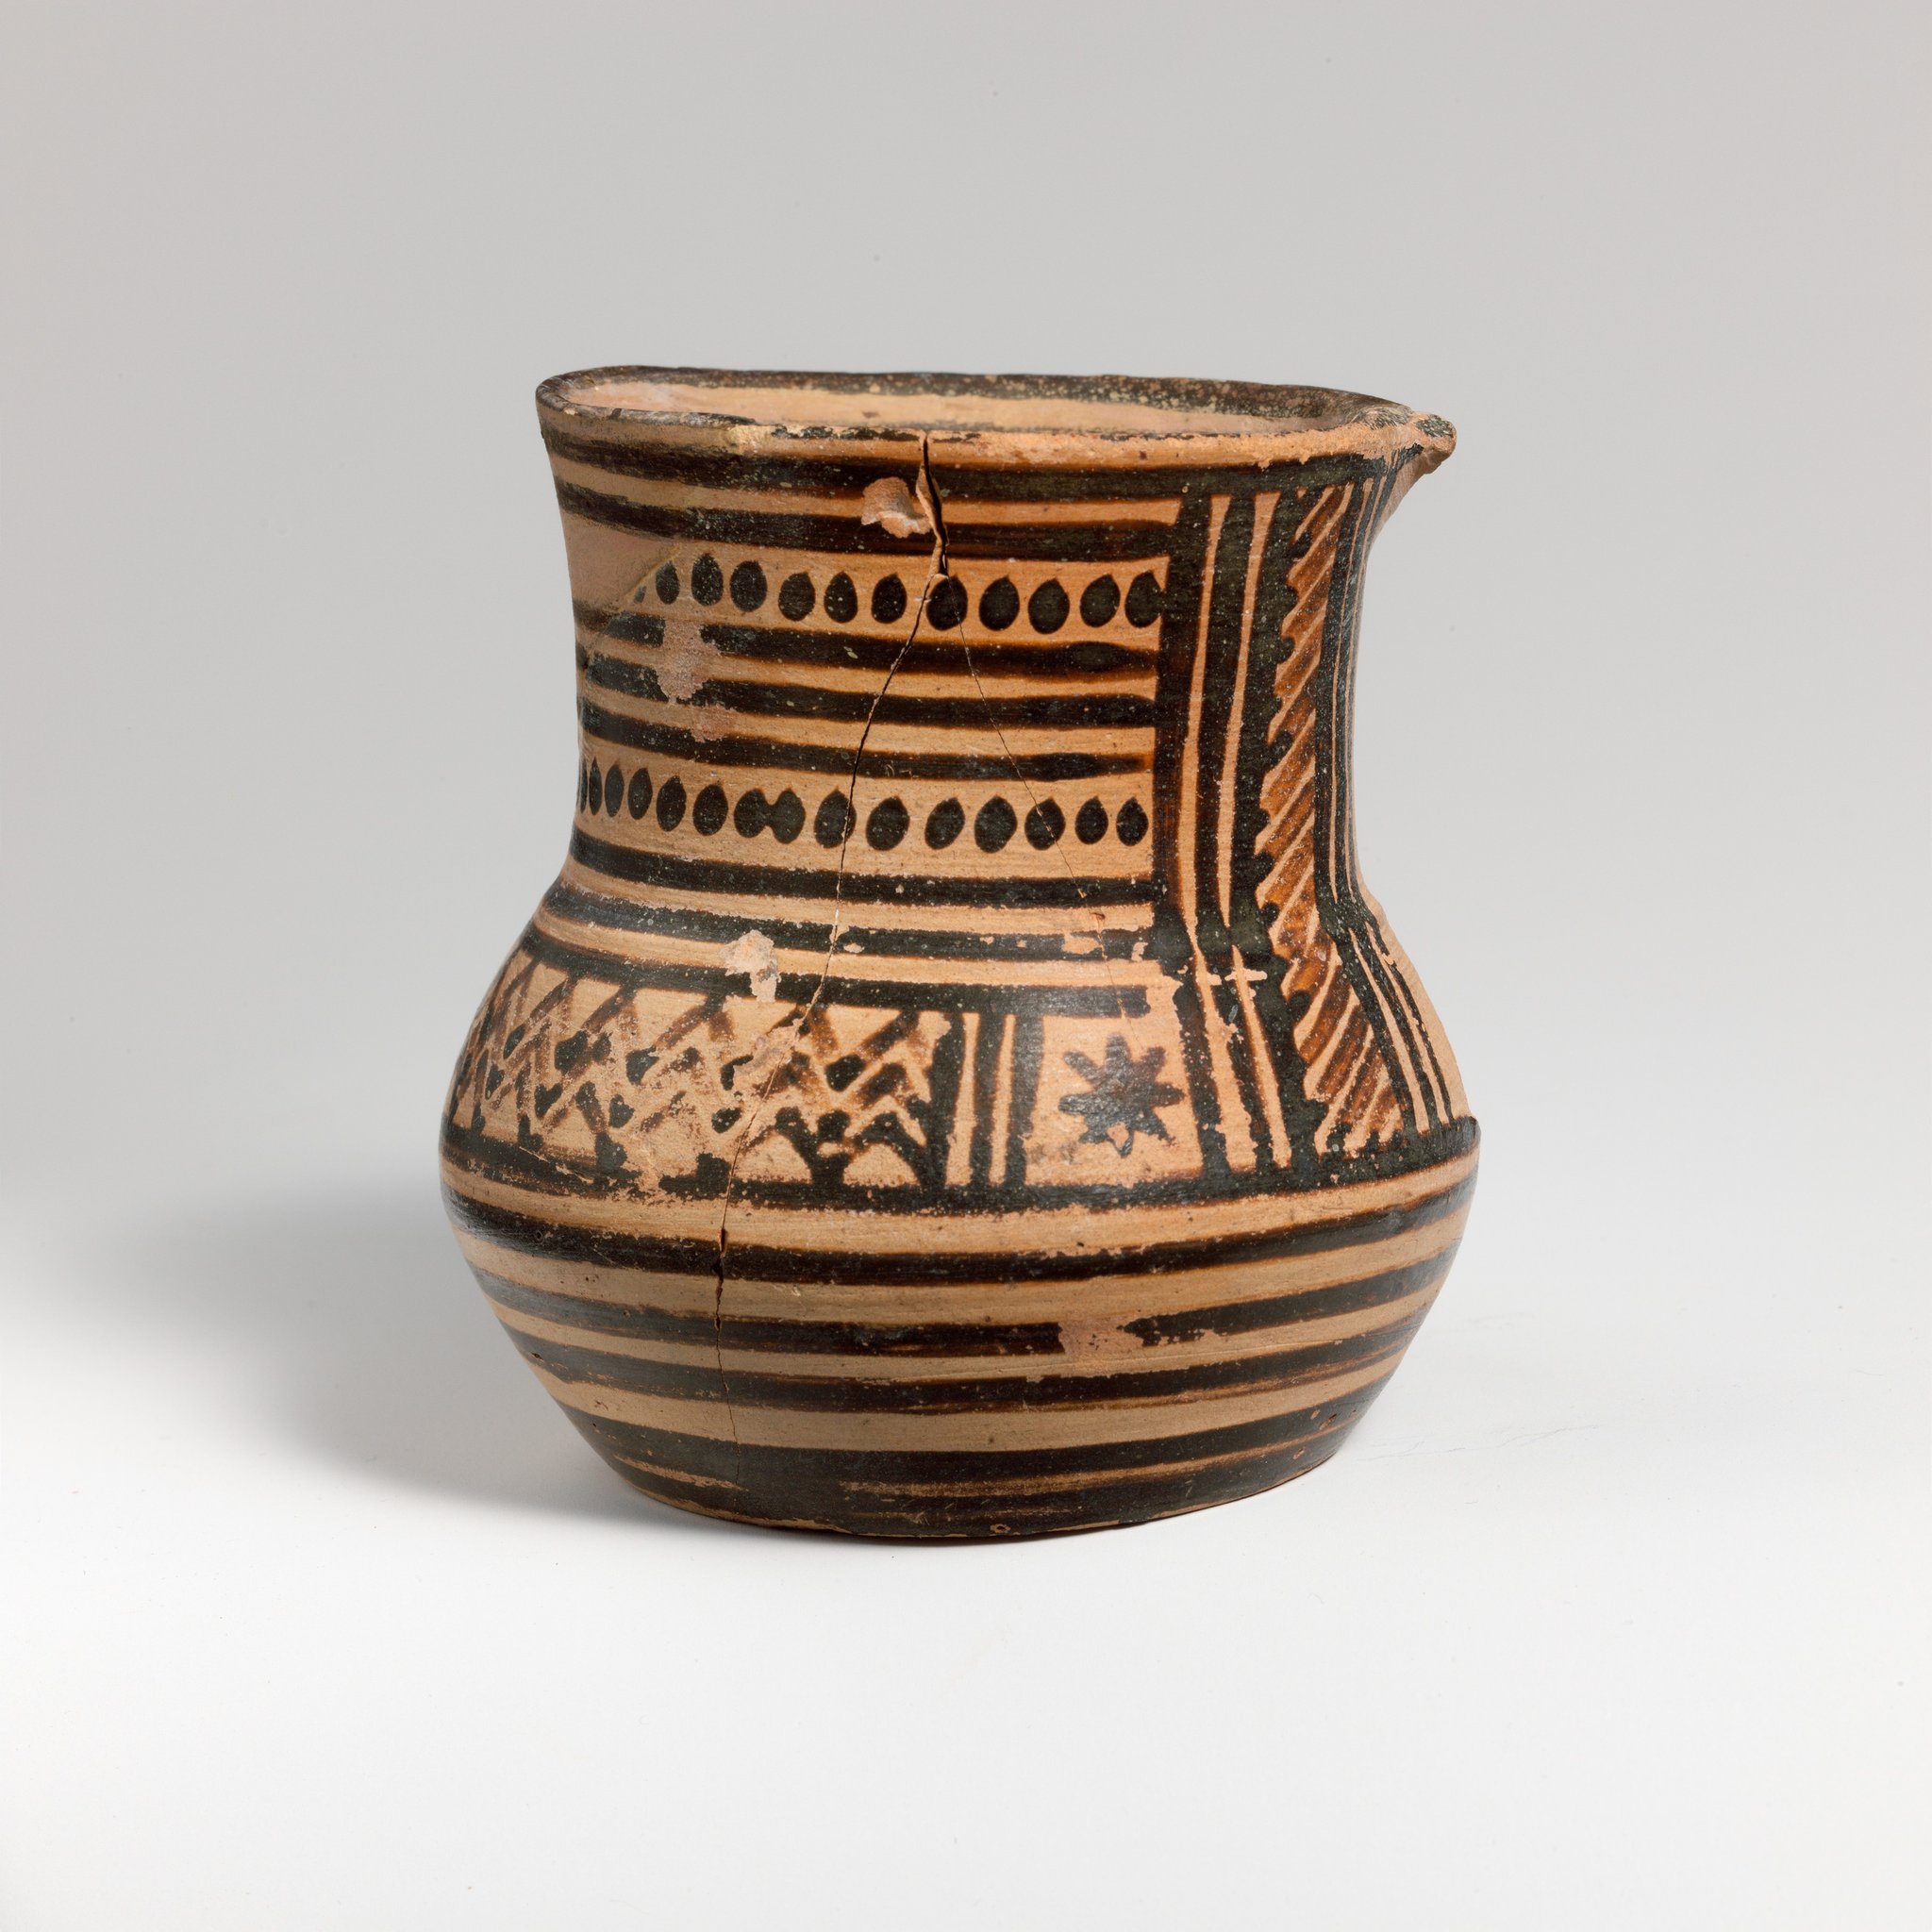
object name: tankard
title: Terracotta tankard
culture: greek, attic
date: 834-801 BCE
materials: terracotta